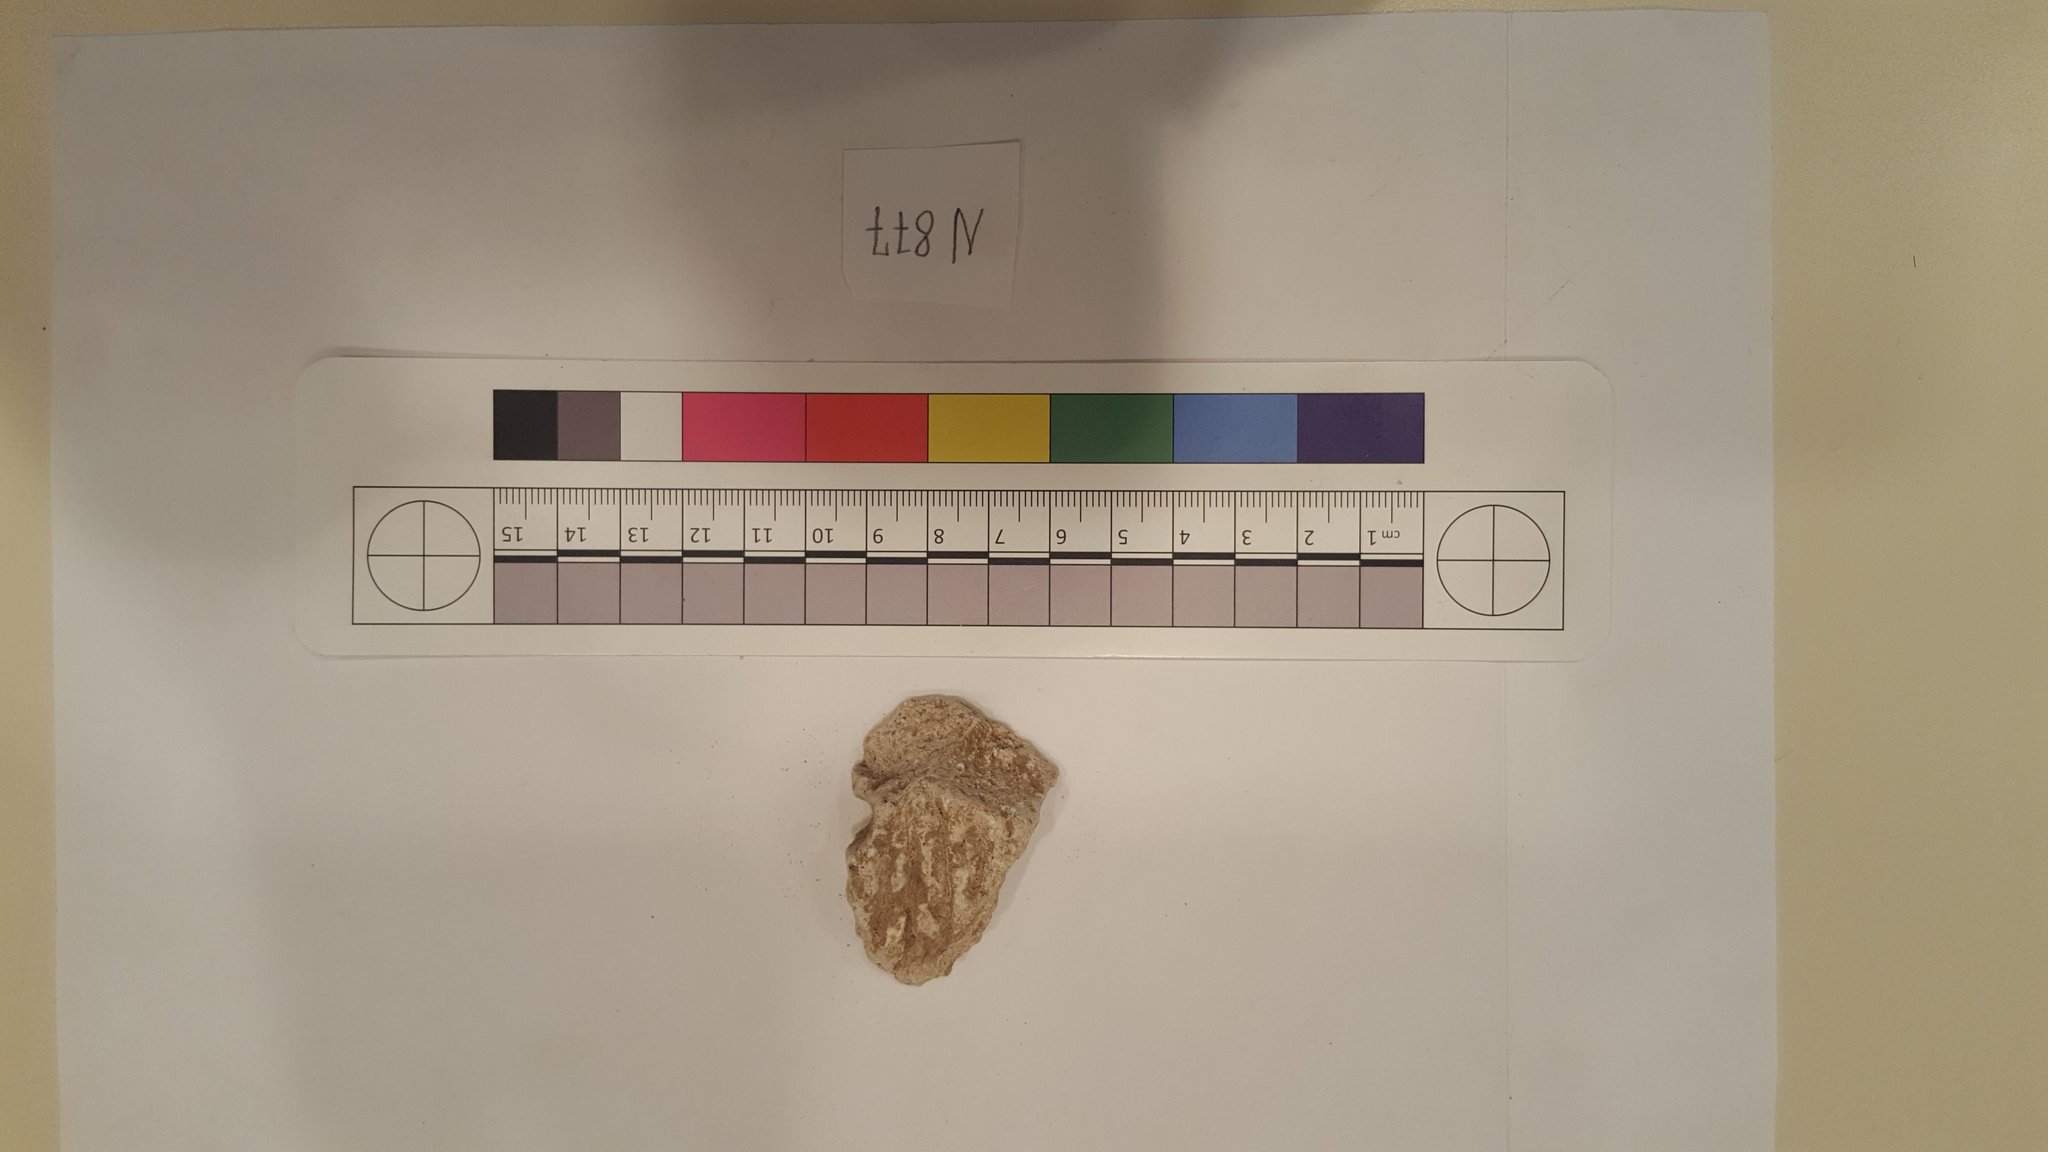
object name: fragment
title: Stucco Fragment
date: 701-1200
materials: plaster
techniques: carving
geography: iran